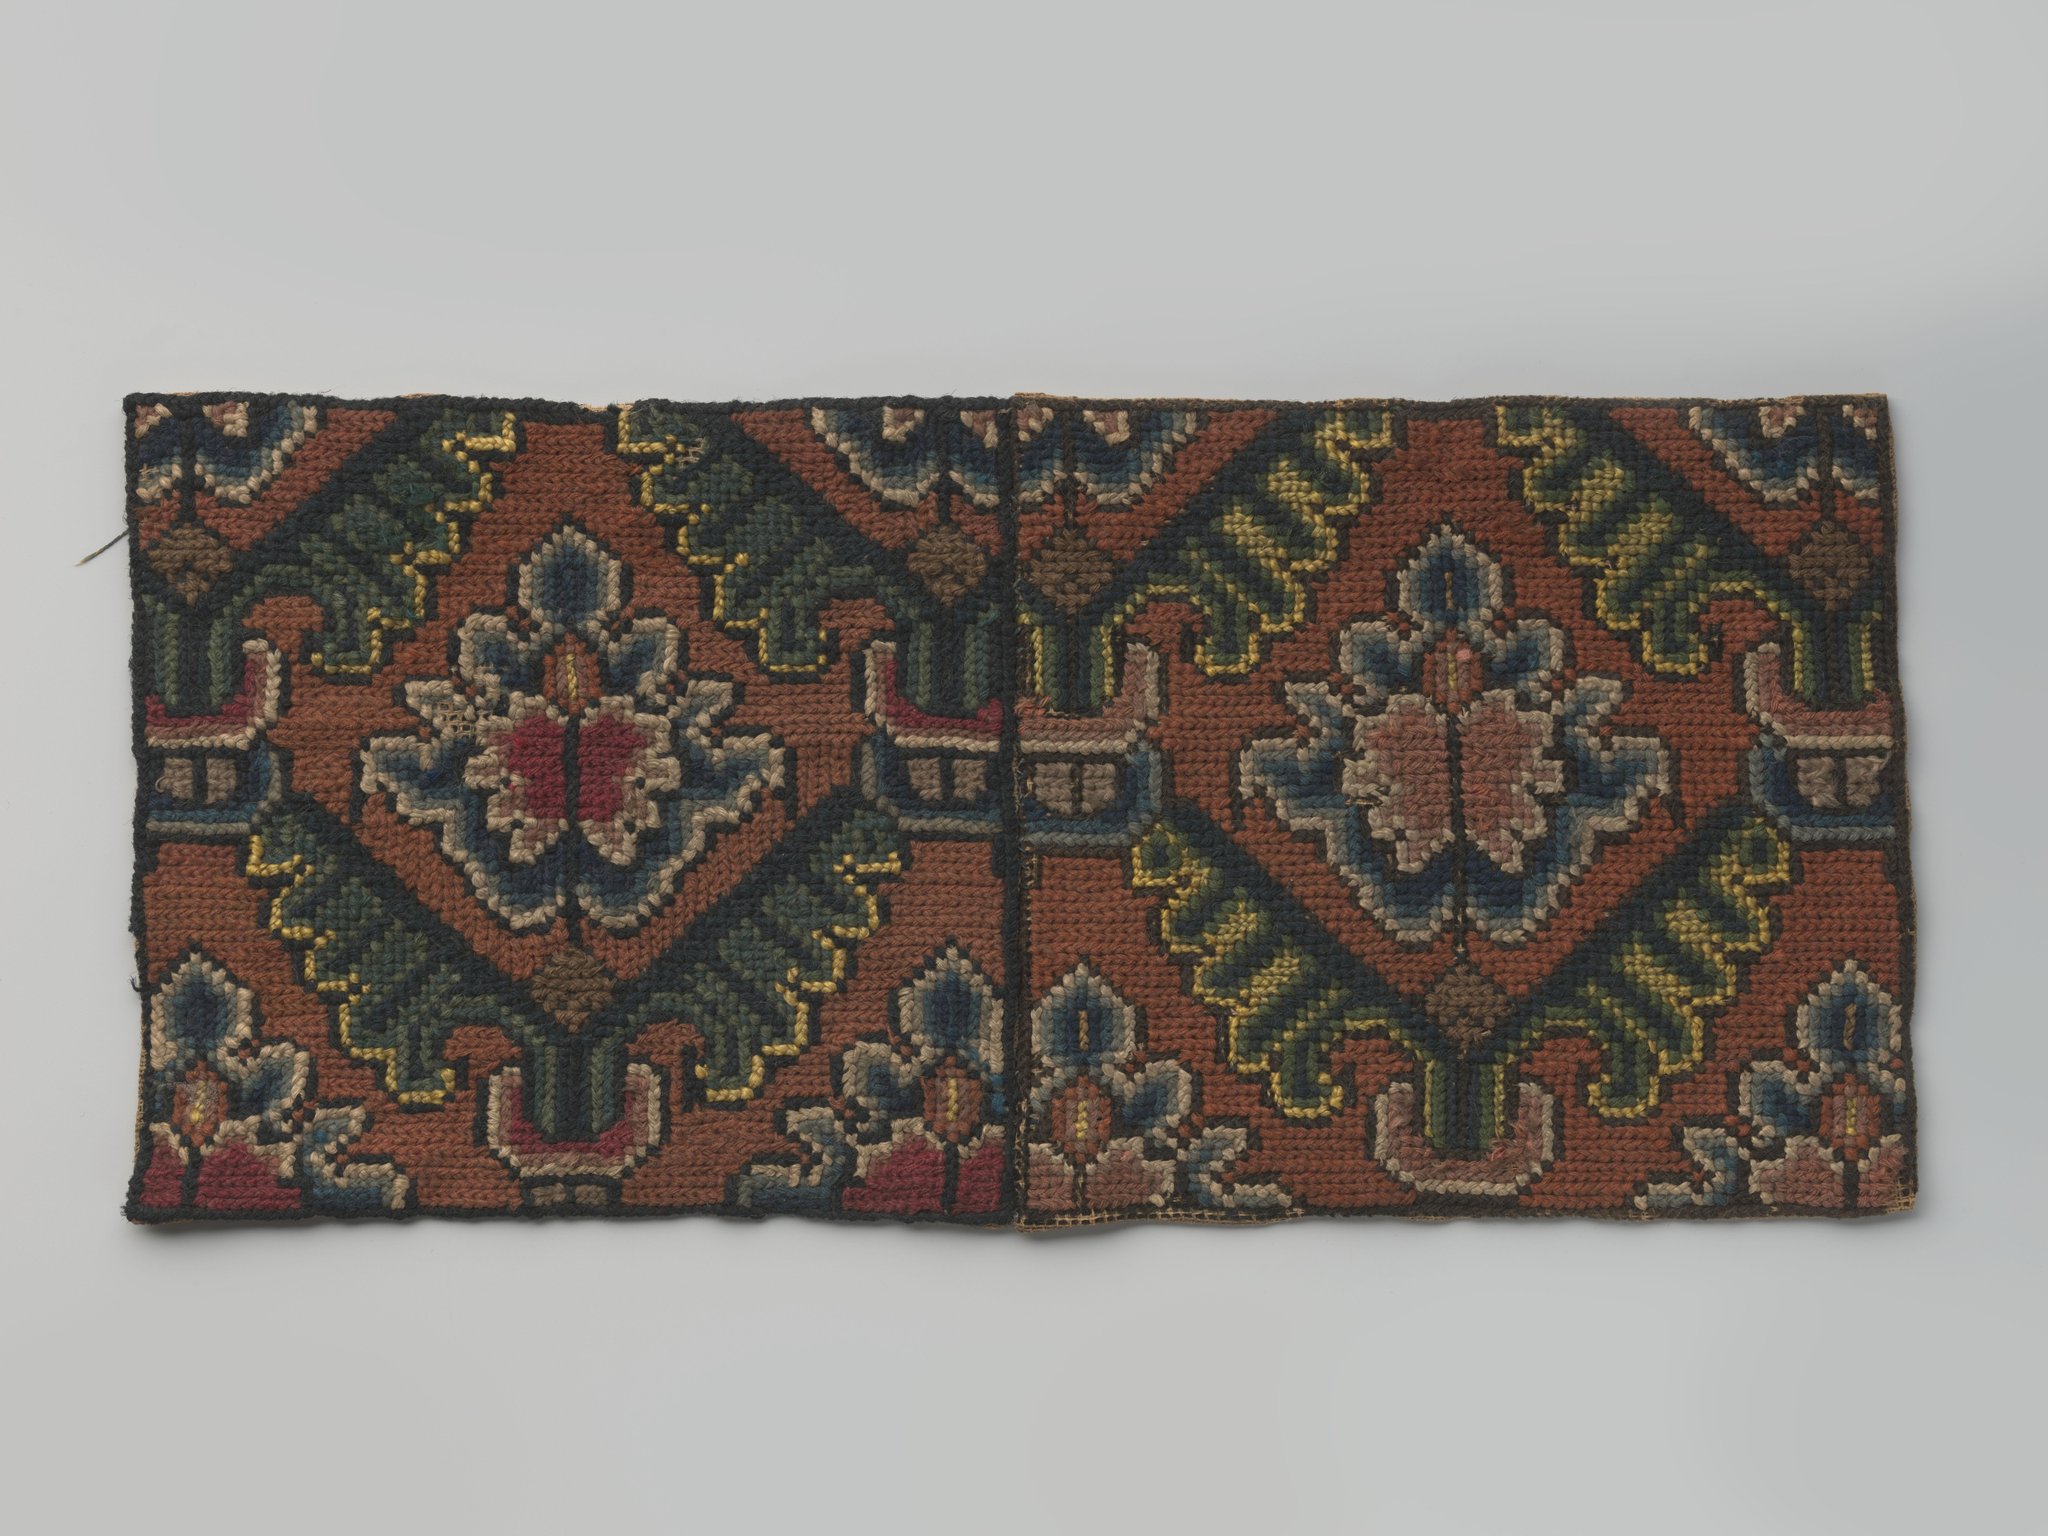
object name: carpet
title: Vloerkleed gemaakt van twee aan elkaar genaaide geborduurde paneeltjes.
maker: Anonymous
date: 1600-1710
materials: linen, silk, wool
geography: southern germany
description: Vloerkleed, gemaakt van twee aan elkaar genaaide geborduurde paneeltjes; bestaande uit een linnen stramien met in vlechtsteek-techniek geborduurde veelkleurige gestileerde palmet- en bloem- (of granaatappel?)motieven. Gebruikte materialen zijn wit linnen gele zijde en de overige kleuren in wol.